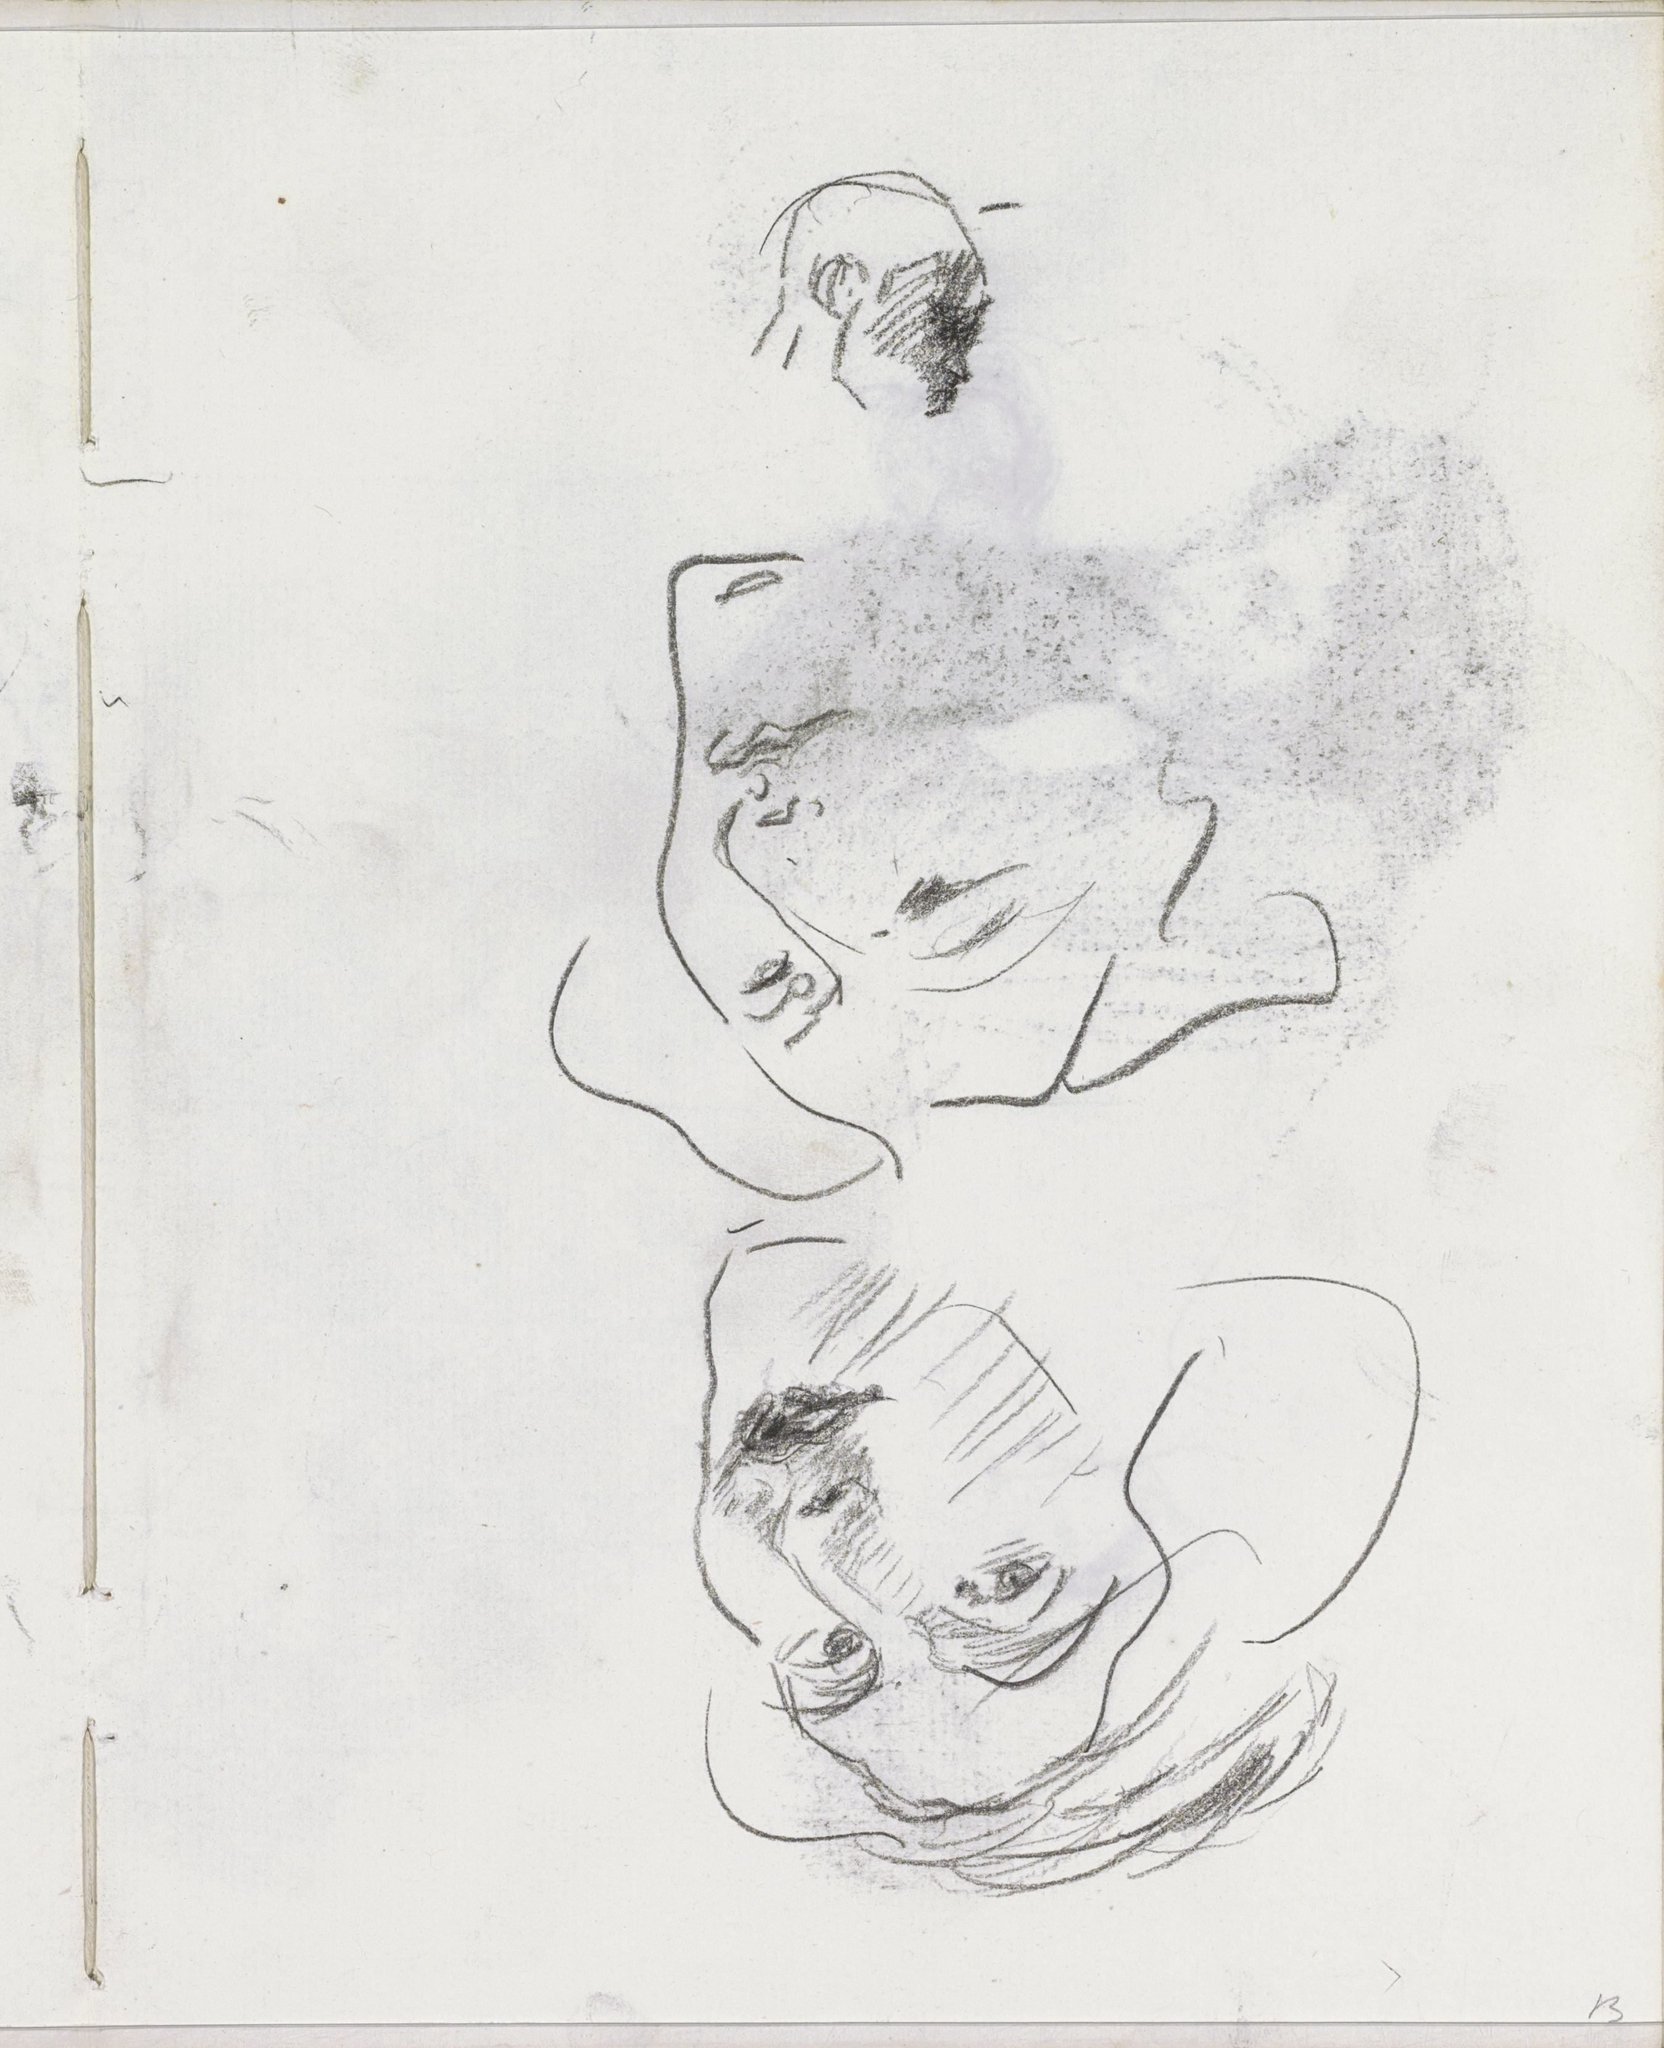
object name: sketchbook leaf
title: Twee vrouwenhoofden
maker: isaac israels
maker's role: draughtsman, painter, print maker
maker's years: 1865-1934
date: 1875-1934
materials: chalk, paper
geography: the hague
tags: head (human) - aa - female human figure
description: Boven nog een hoofd. Blad 13 recto uit schetsboek XIII met 25 bladen.